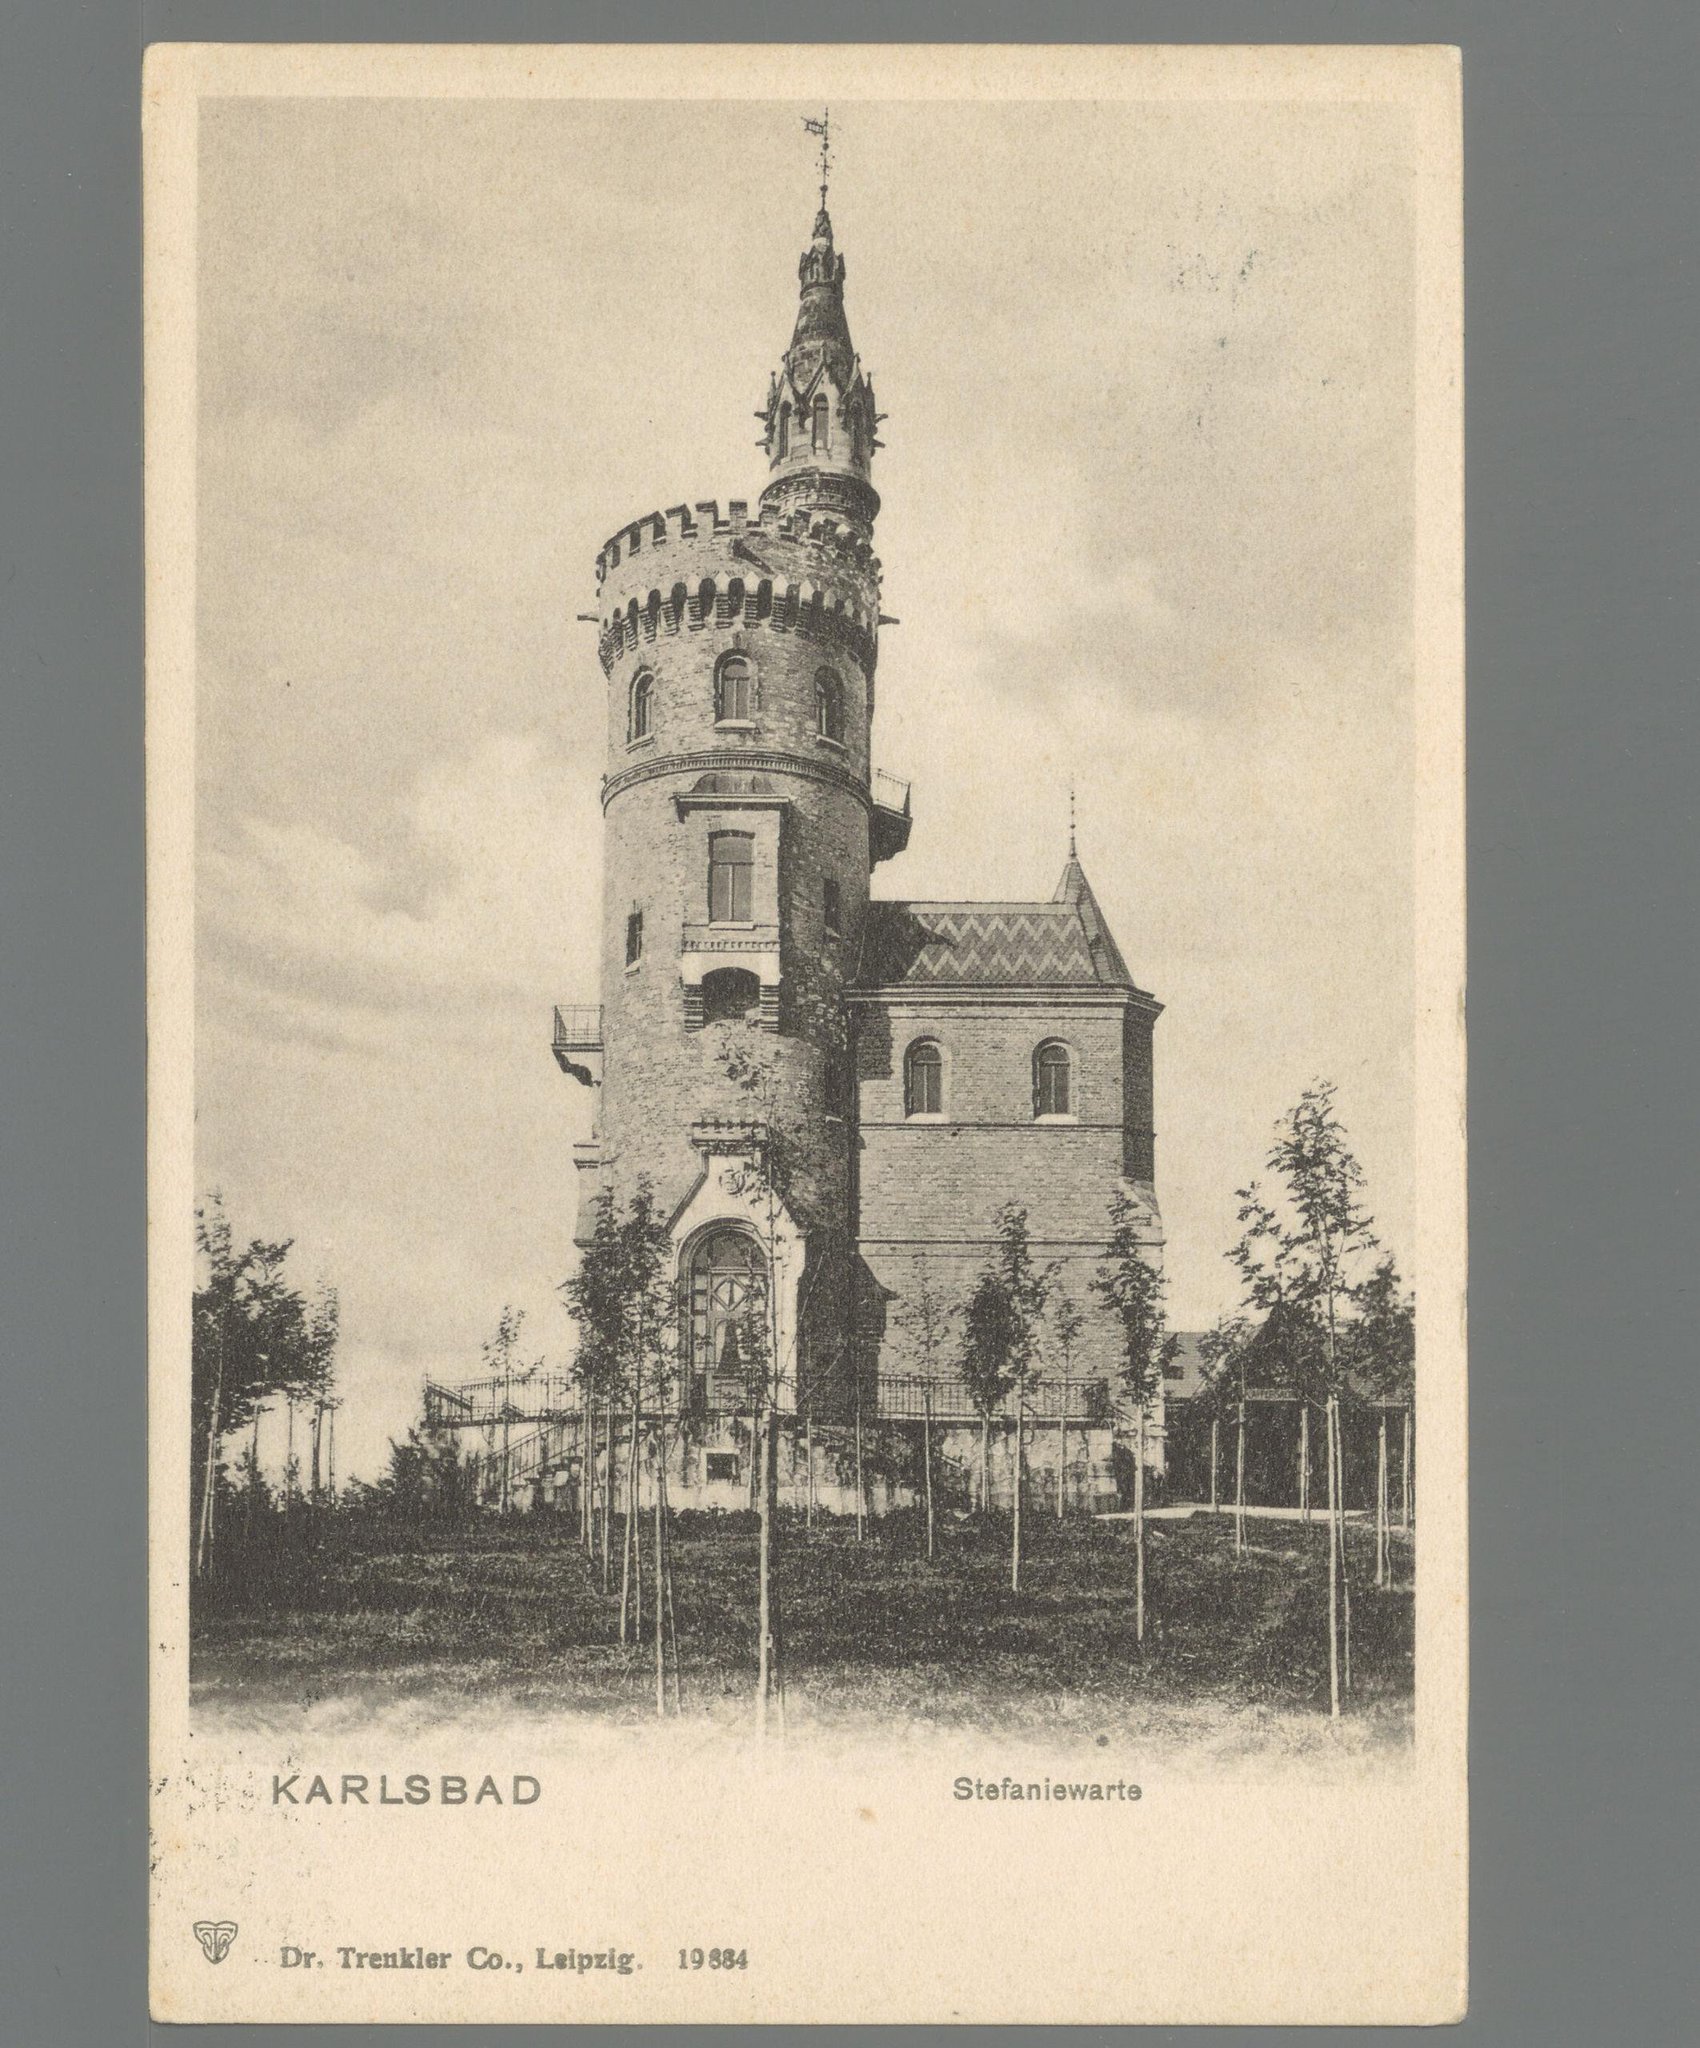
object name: photomechanical print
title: Karlsbad. Stefaniewarte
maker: Anonymous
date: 1894-1903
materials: cardboard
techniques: photograph, writing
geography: leipzig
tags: tower, clock tower ~ monumental adornment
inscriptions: postage stamp